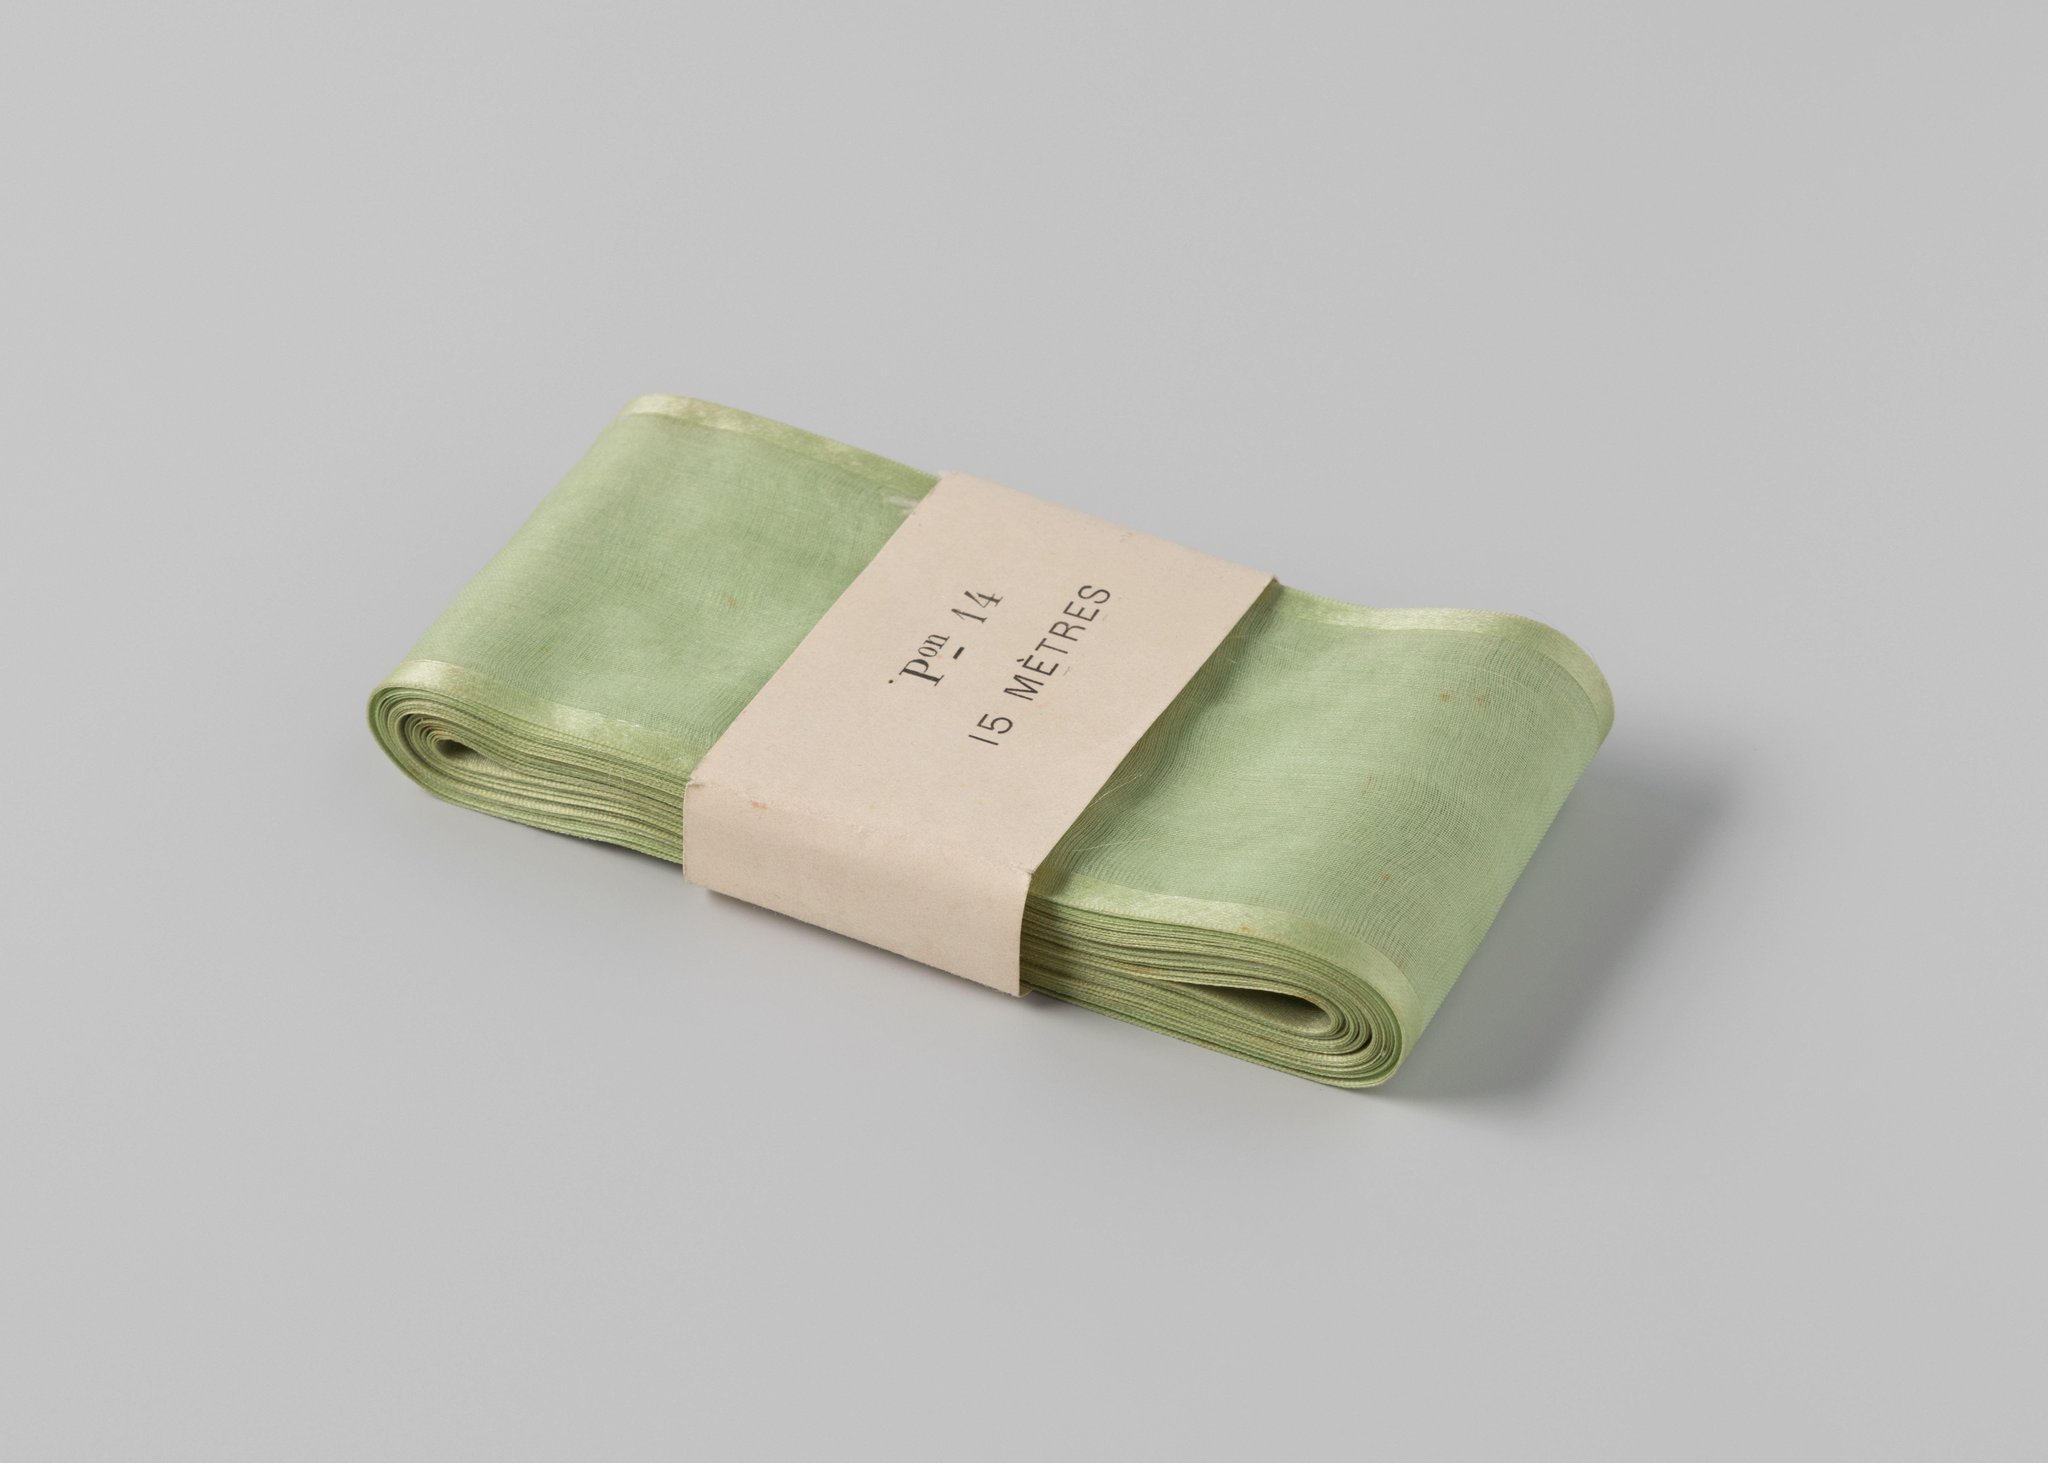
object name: ribbon material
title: Lint van lichtgroen gaas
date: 1900-1915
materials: textile, silk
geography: nijmegen